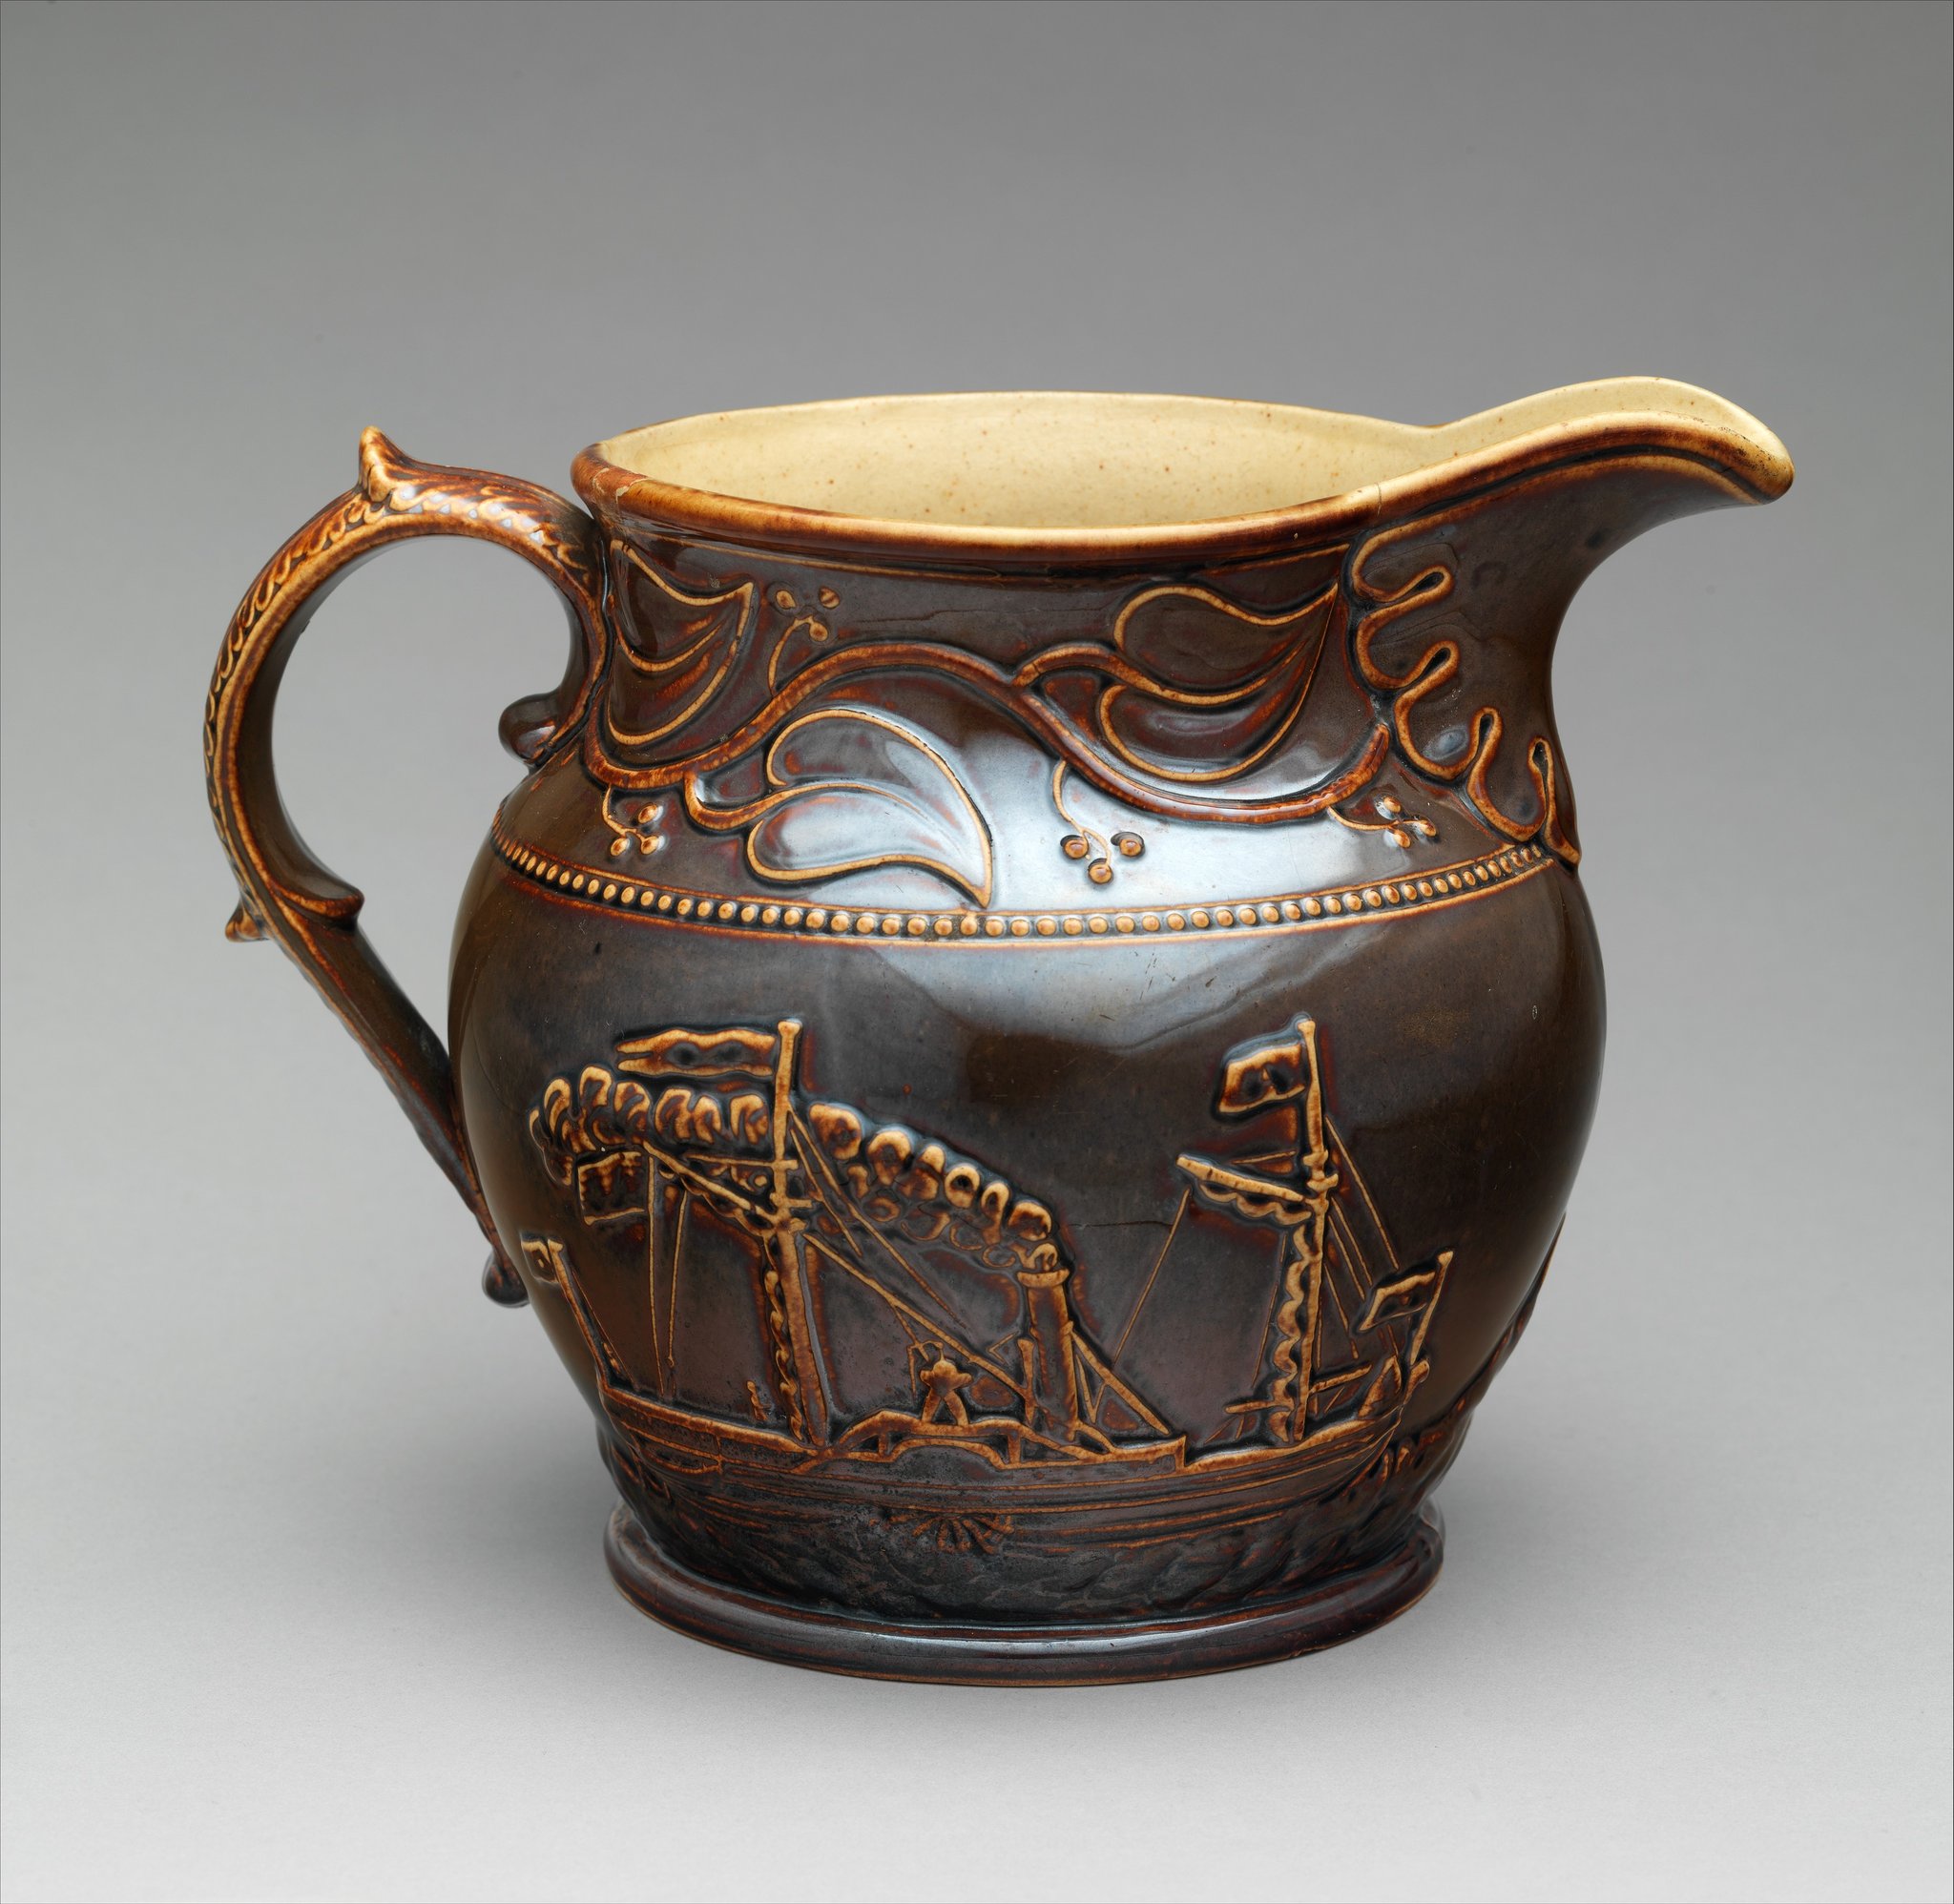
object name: pitcher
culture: american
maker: salamander works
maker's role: manufacturer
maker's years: 1825-1912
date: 1836-1850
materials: glaze, stoneware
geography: united states